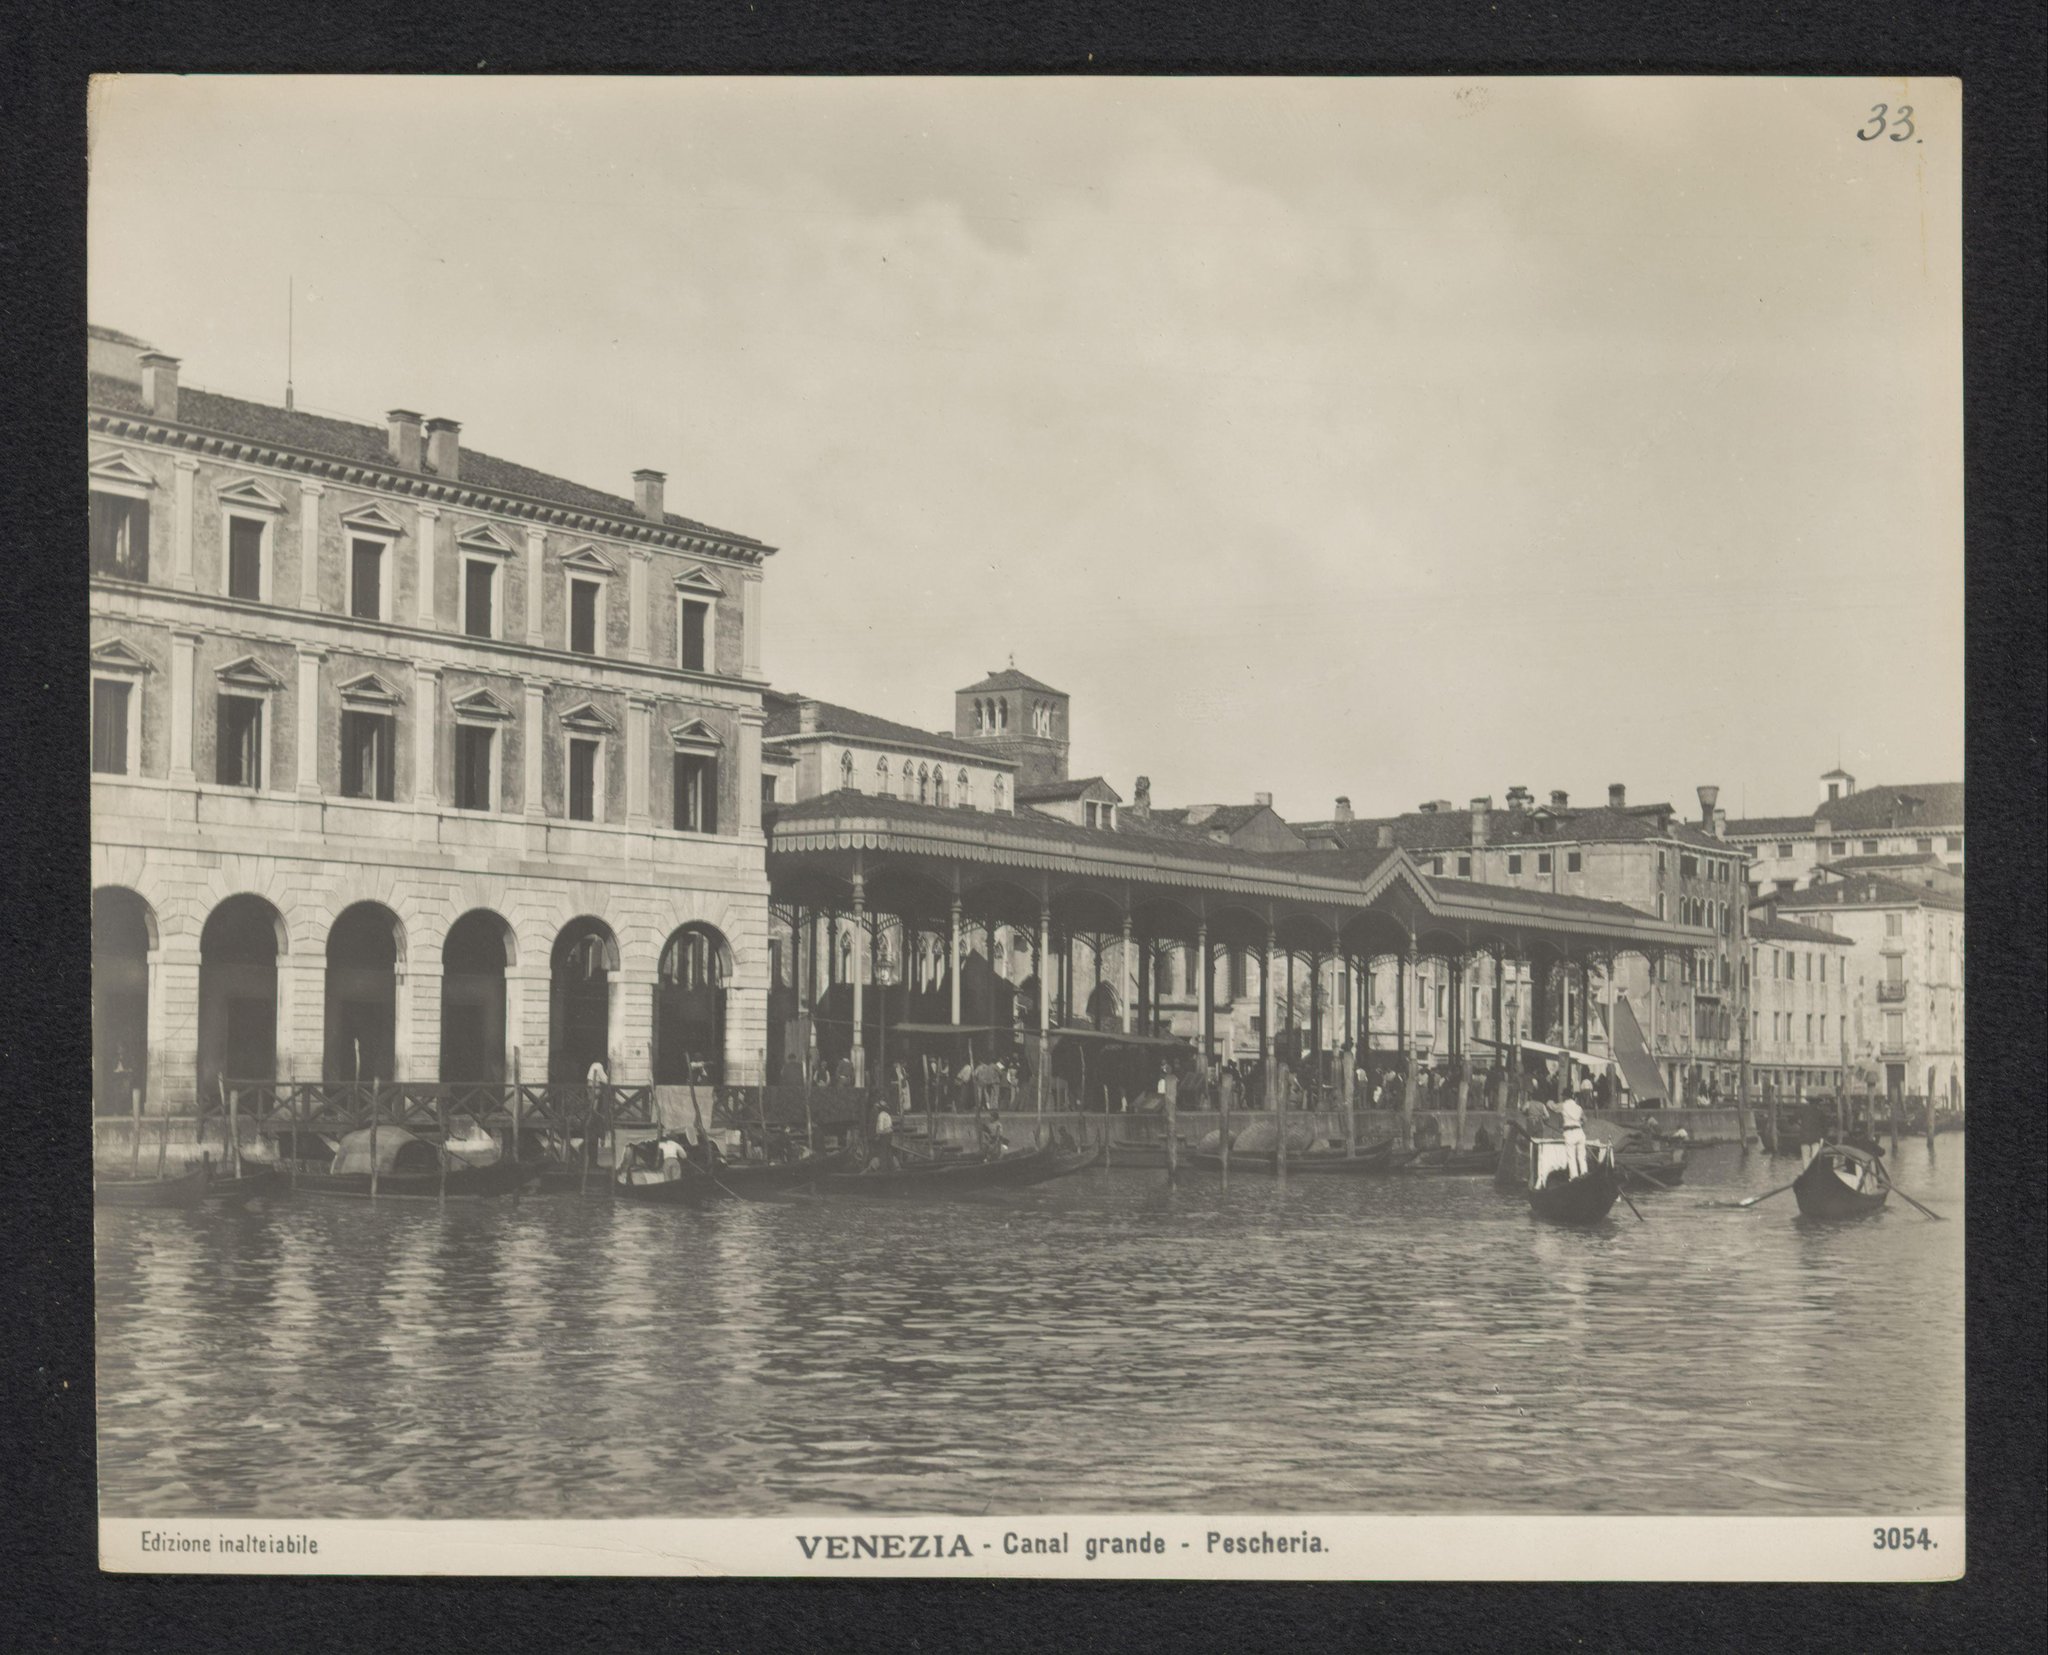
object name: photograph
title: Venezia - Canal Grande - Pescheria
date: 1900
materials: cardboard, photographic support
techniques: gelatin silver print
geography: venice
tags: canal, façade (of house or building), market-hall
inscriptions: number: ‘33.’, number: ‘3054.’